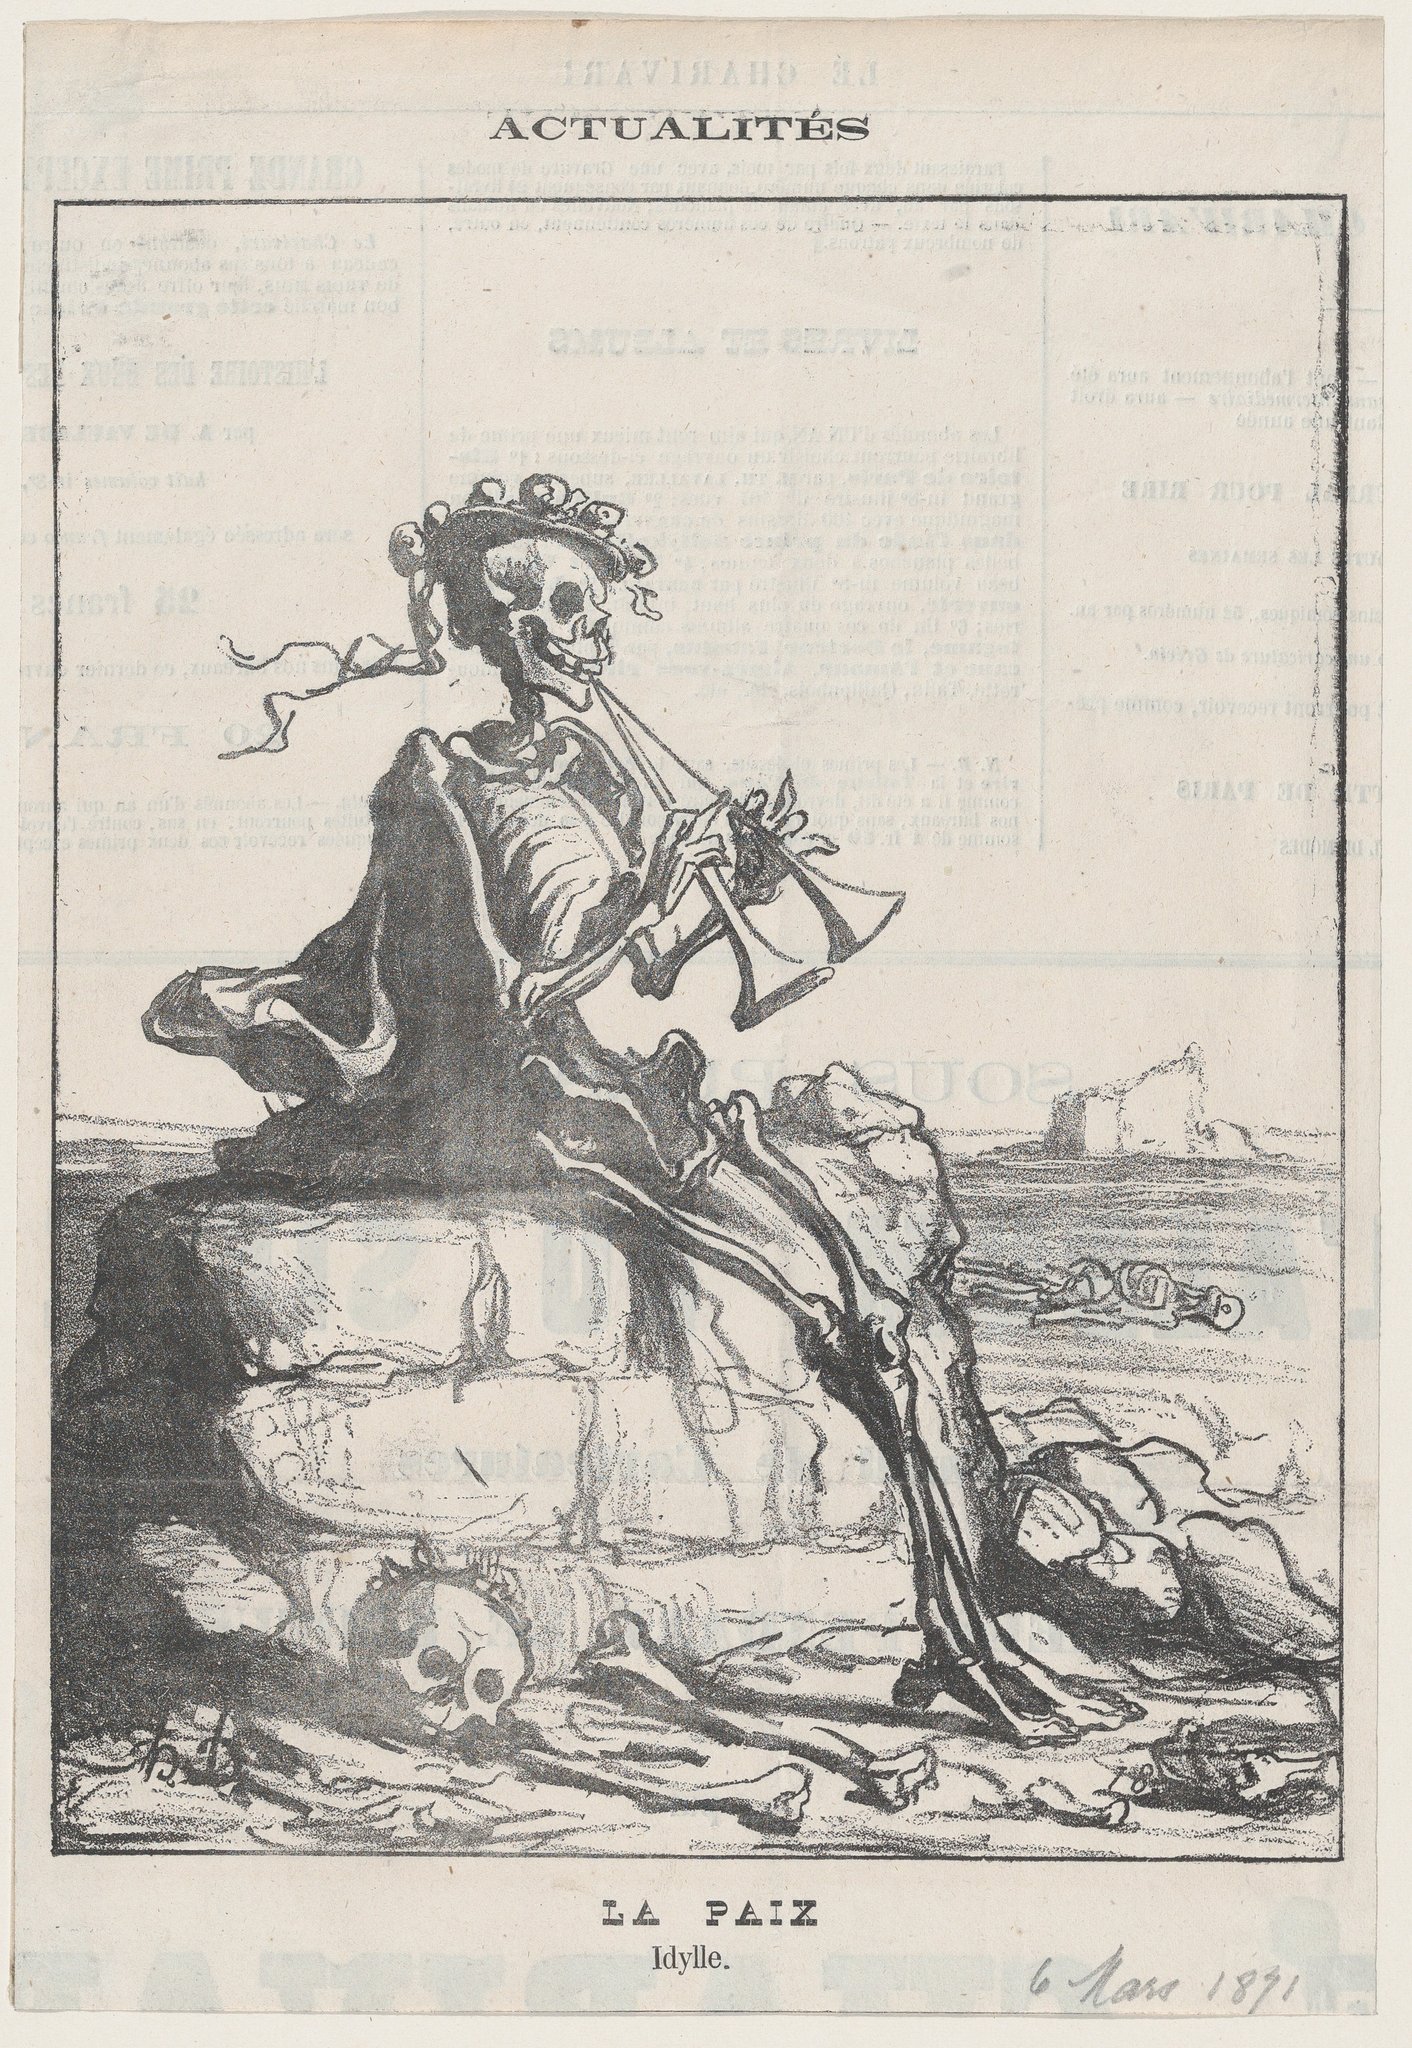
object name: print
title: Peace, an idyll, from 'News of the day,' published in Le Charivari, March 6, 1871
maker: honoré daumier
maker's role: artist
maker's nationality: french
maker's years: 1808-1879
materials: paper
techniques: lithograph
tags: skeletons,horns